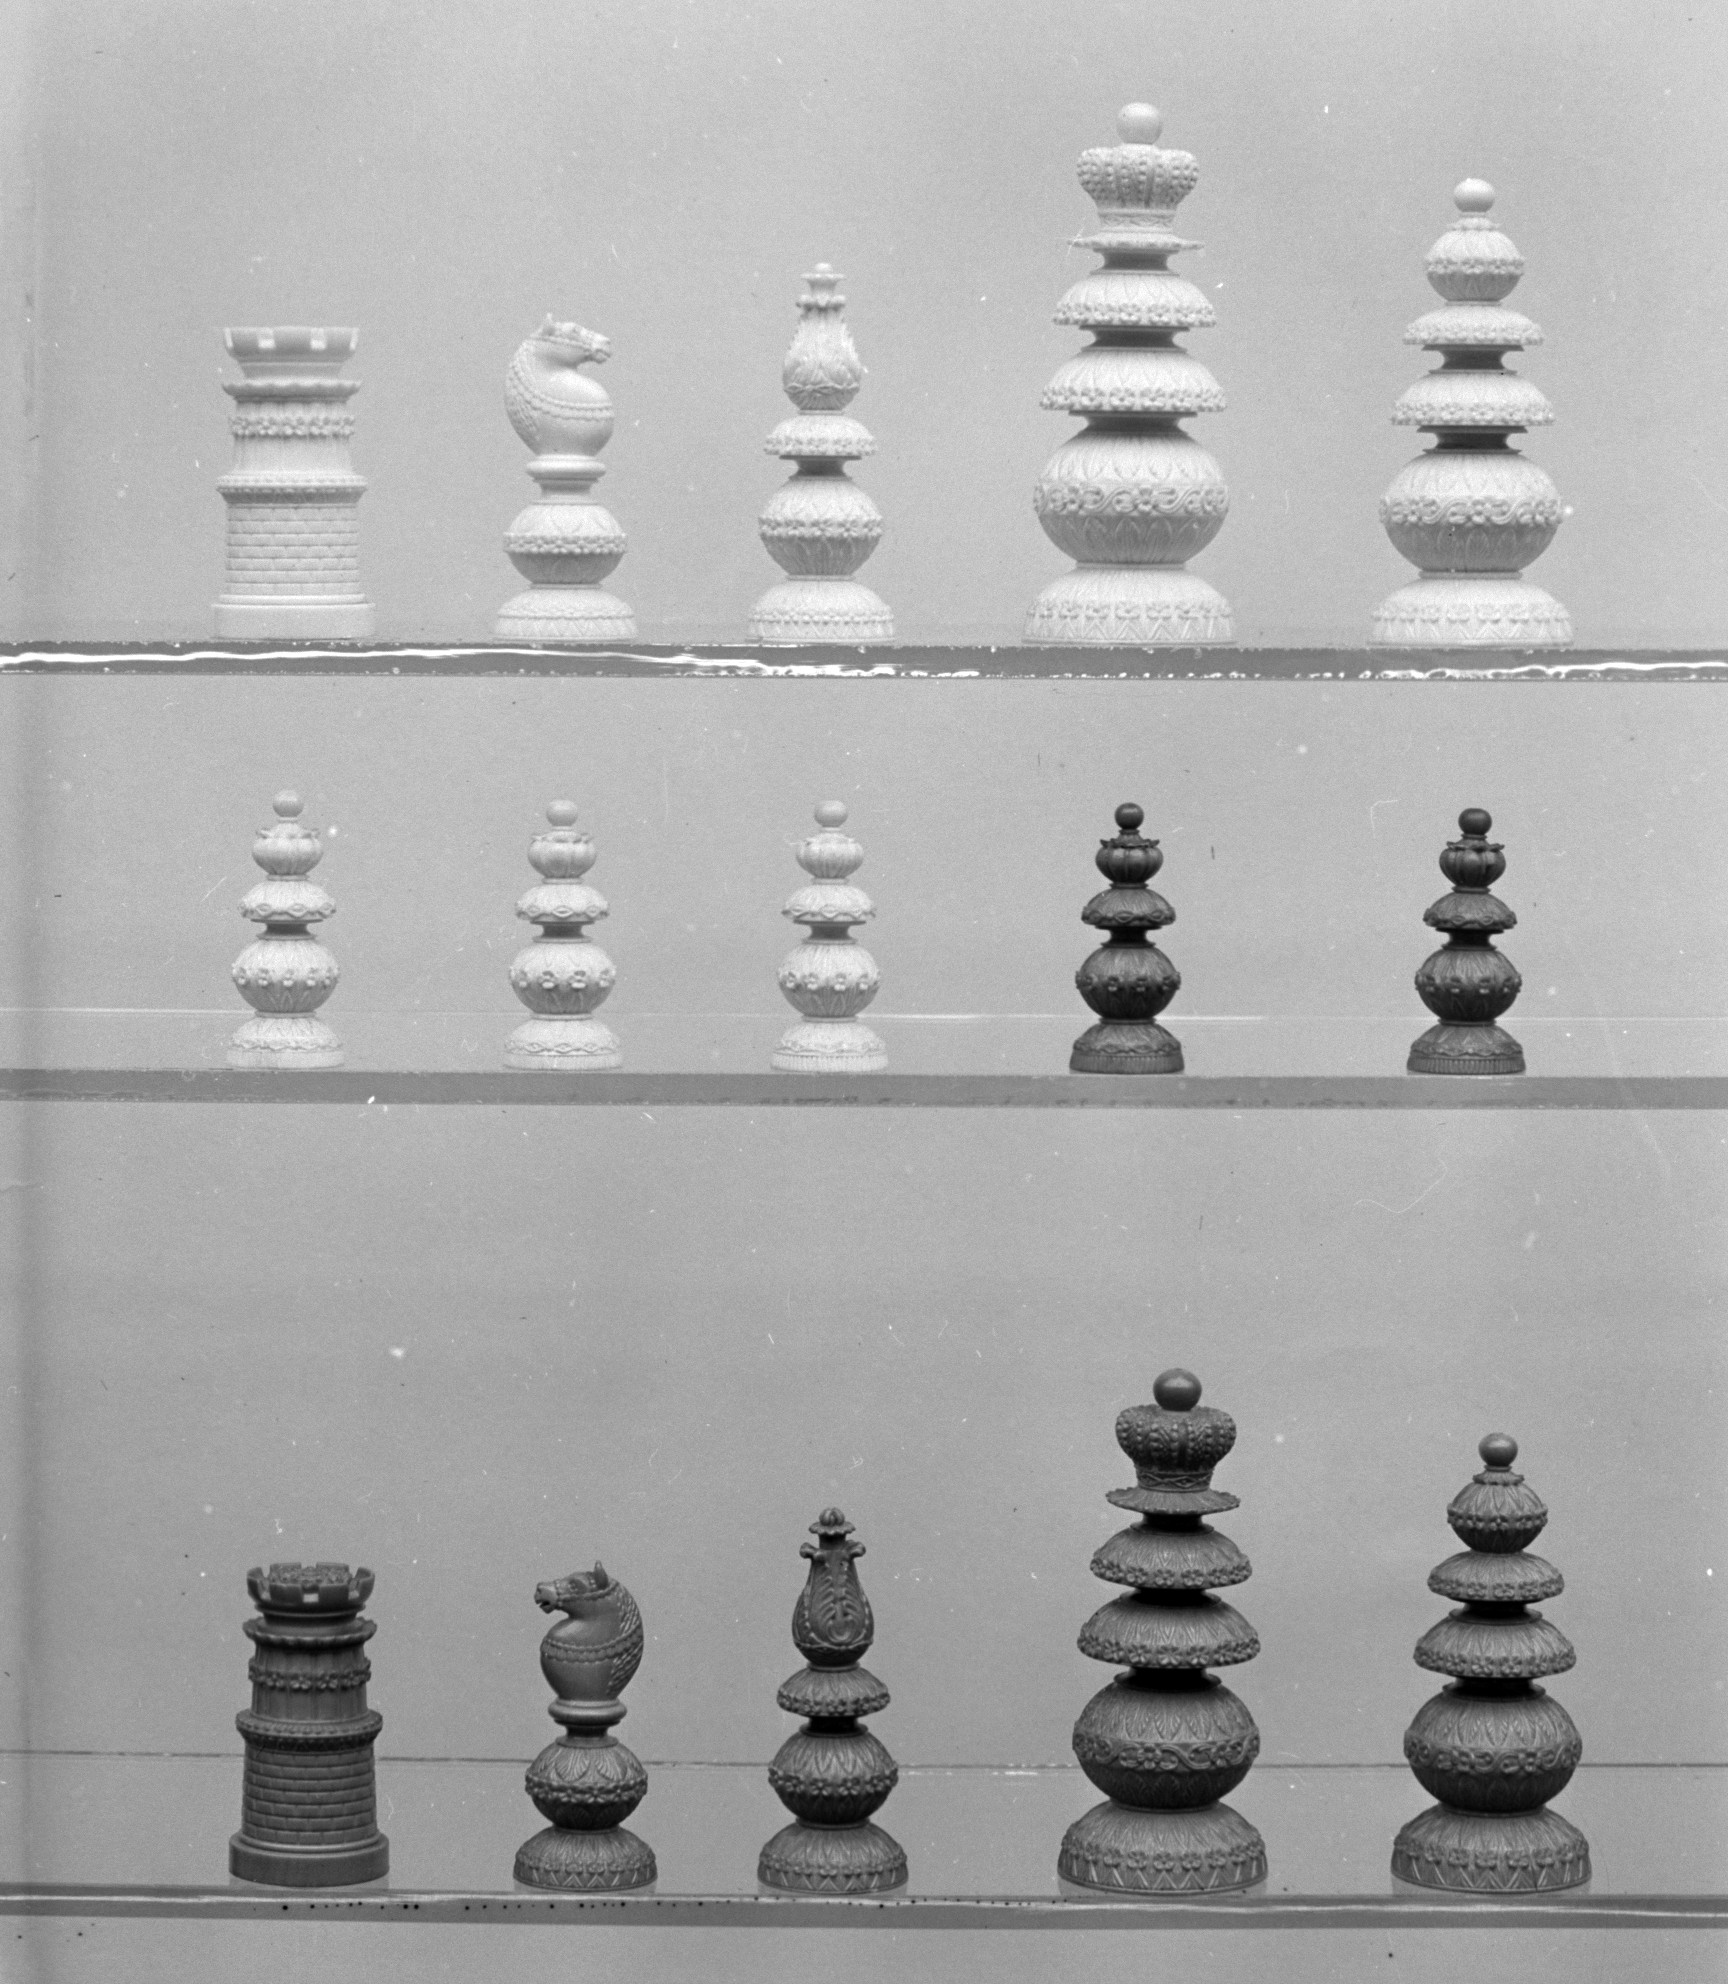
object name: chessman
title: Chessmen (32)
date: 1801-1900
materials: ivory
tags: chess,games